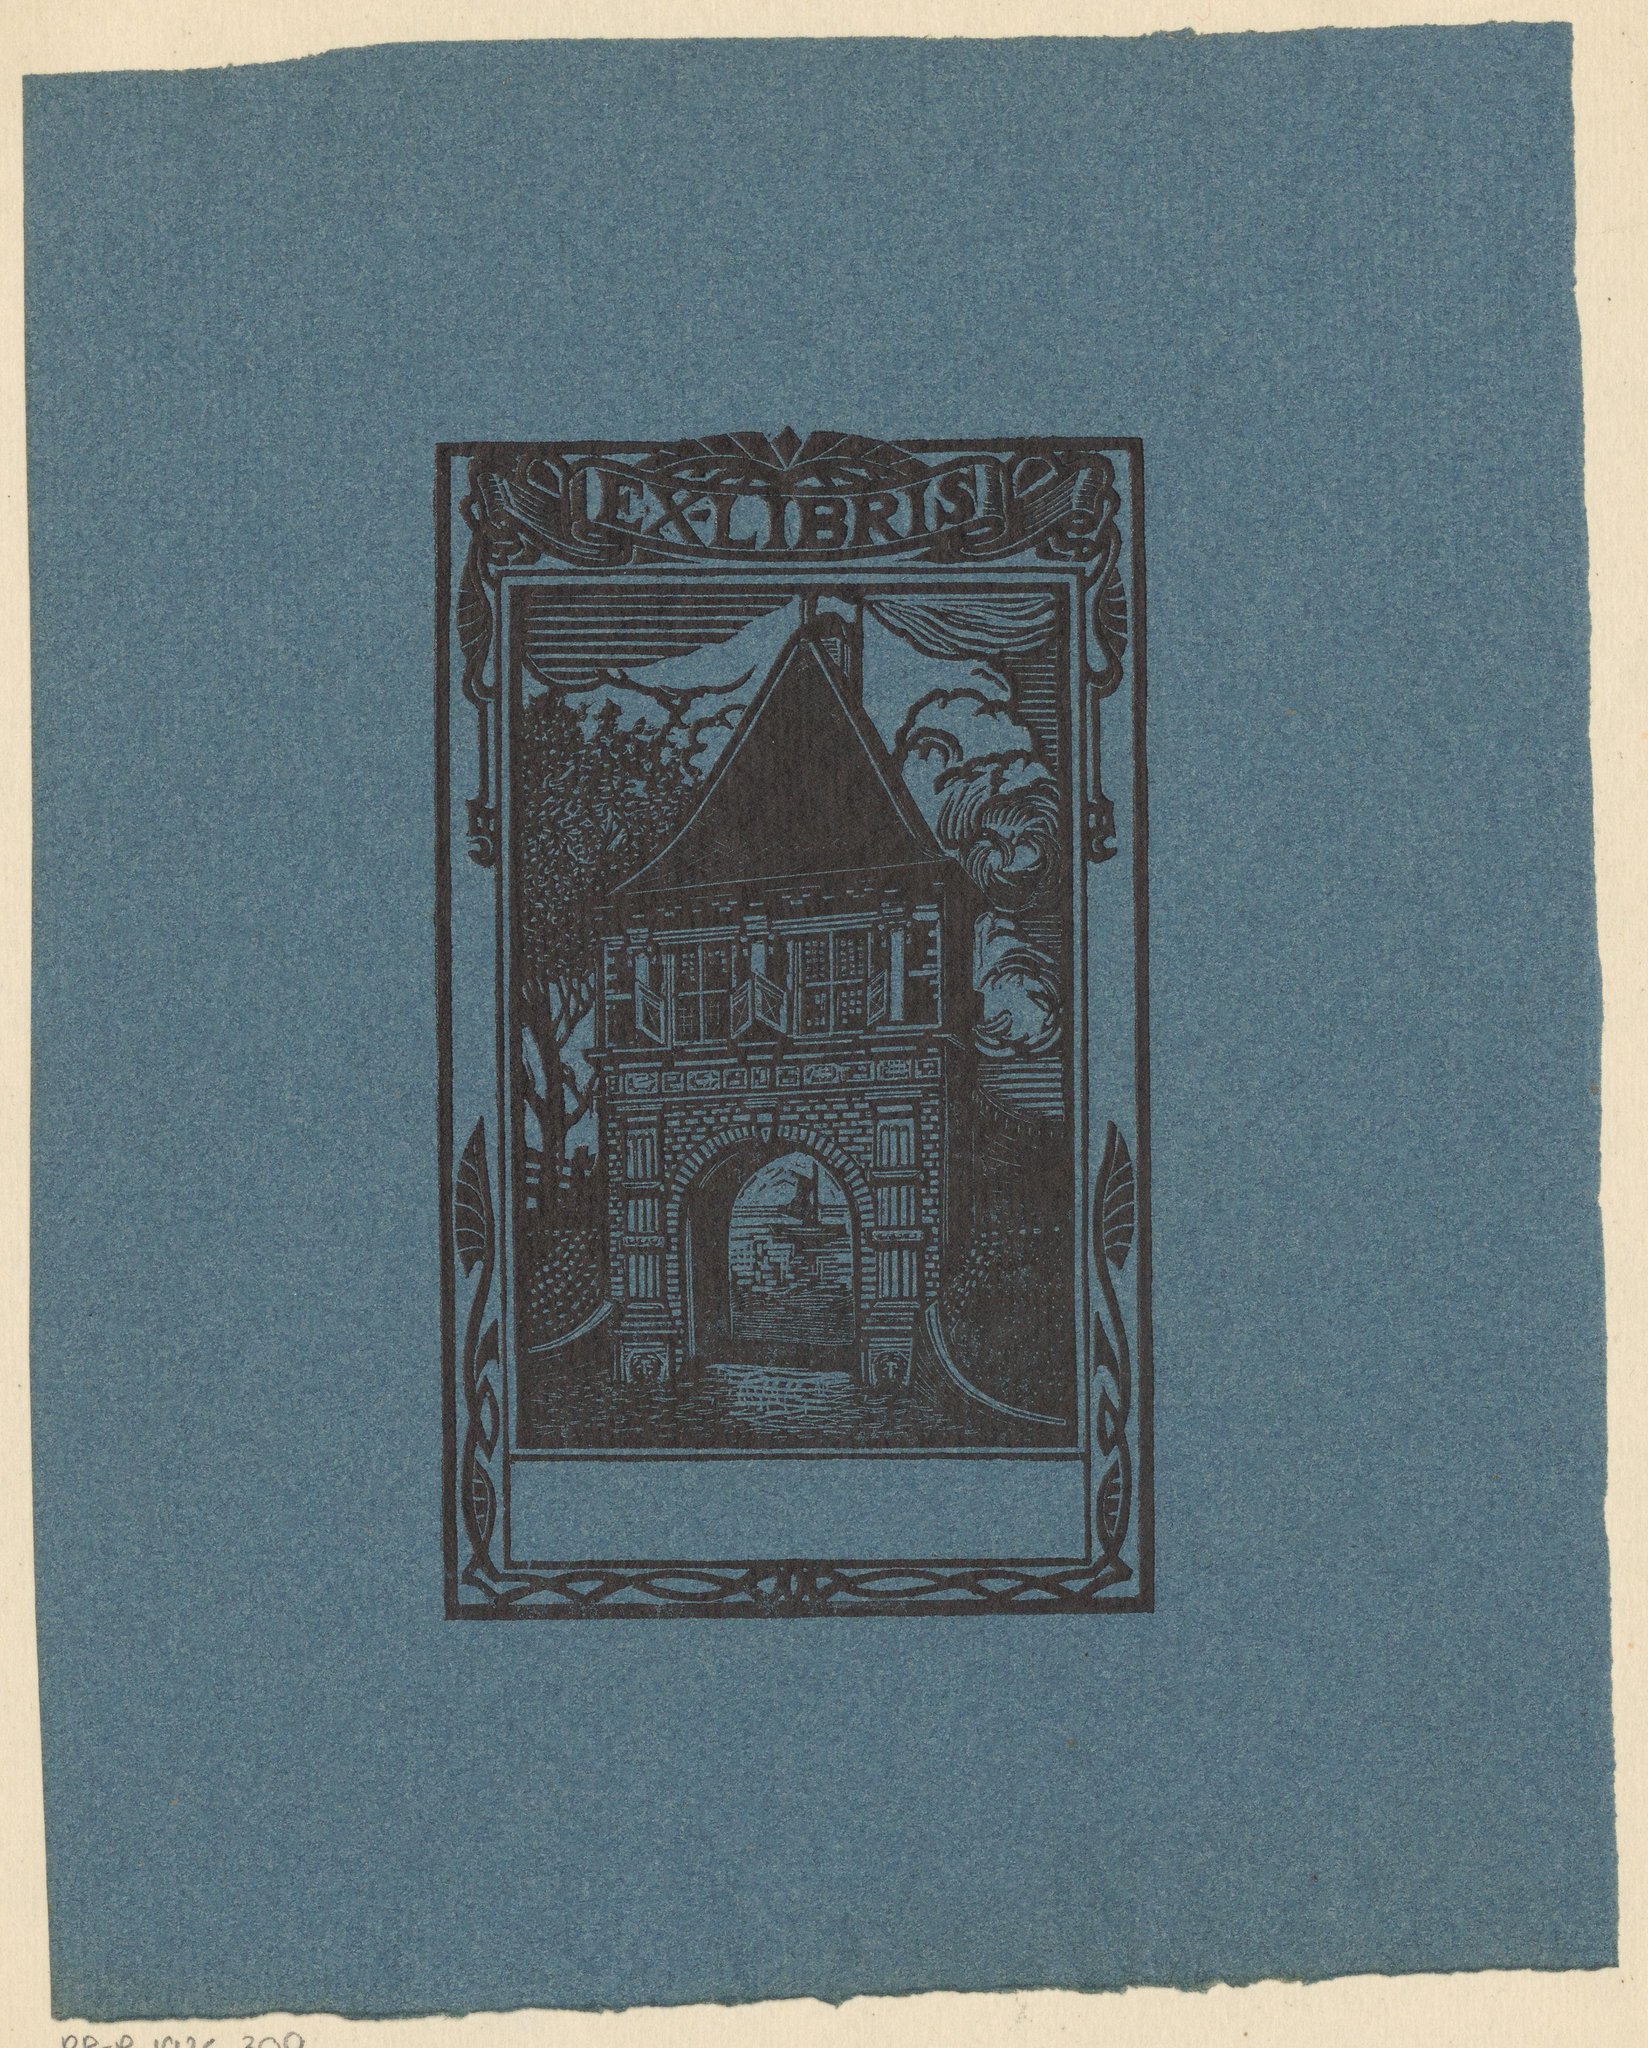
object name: bookplate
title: Ex libris van onbekend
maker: johannes josephus aarts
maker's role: draughtsman, print maker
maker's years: 1871-1934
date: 1881-1926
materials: paper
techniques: woodcut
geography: netherlands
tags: sailing-ship, sailing-boat, lake, village-gate